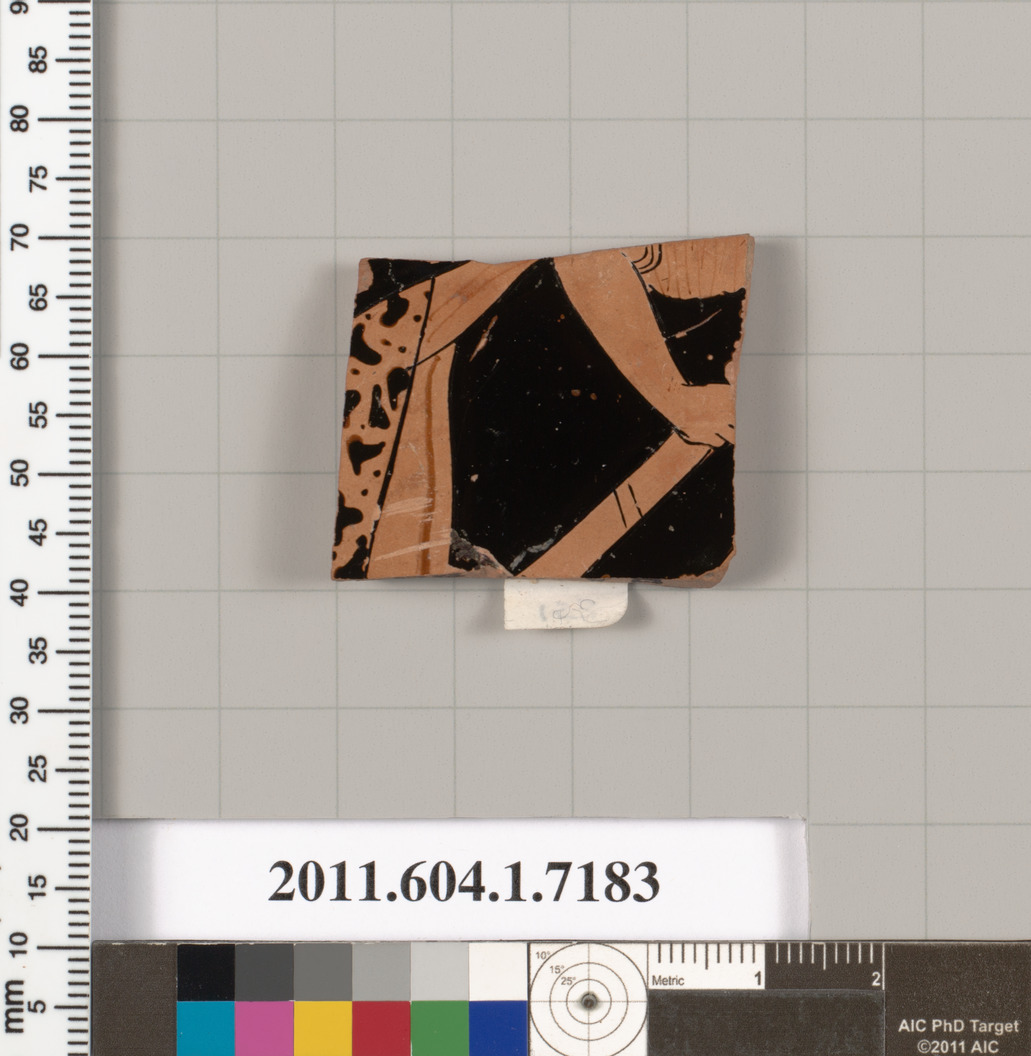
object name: kylix fragment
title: Terracotta fragment of a kylix (drinking cup)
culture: greek, attic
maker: makron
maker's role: artist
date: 500-480 BCE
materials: terracotta